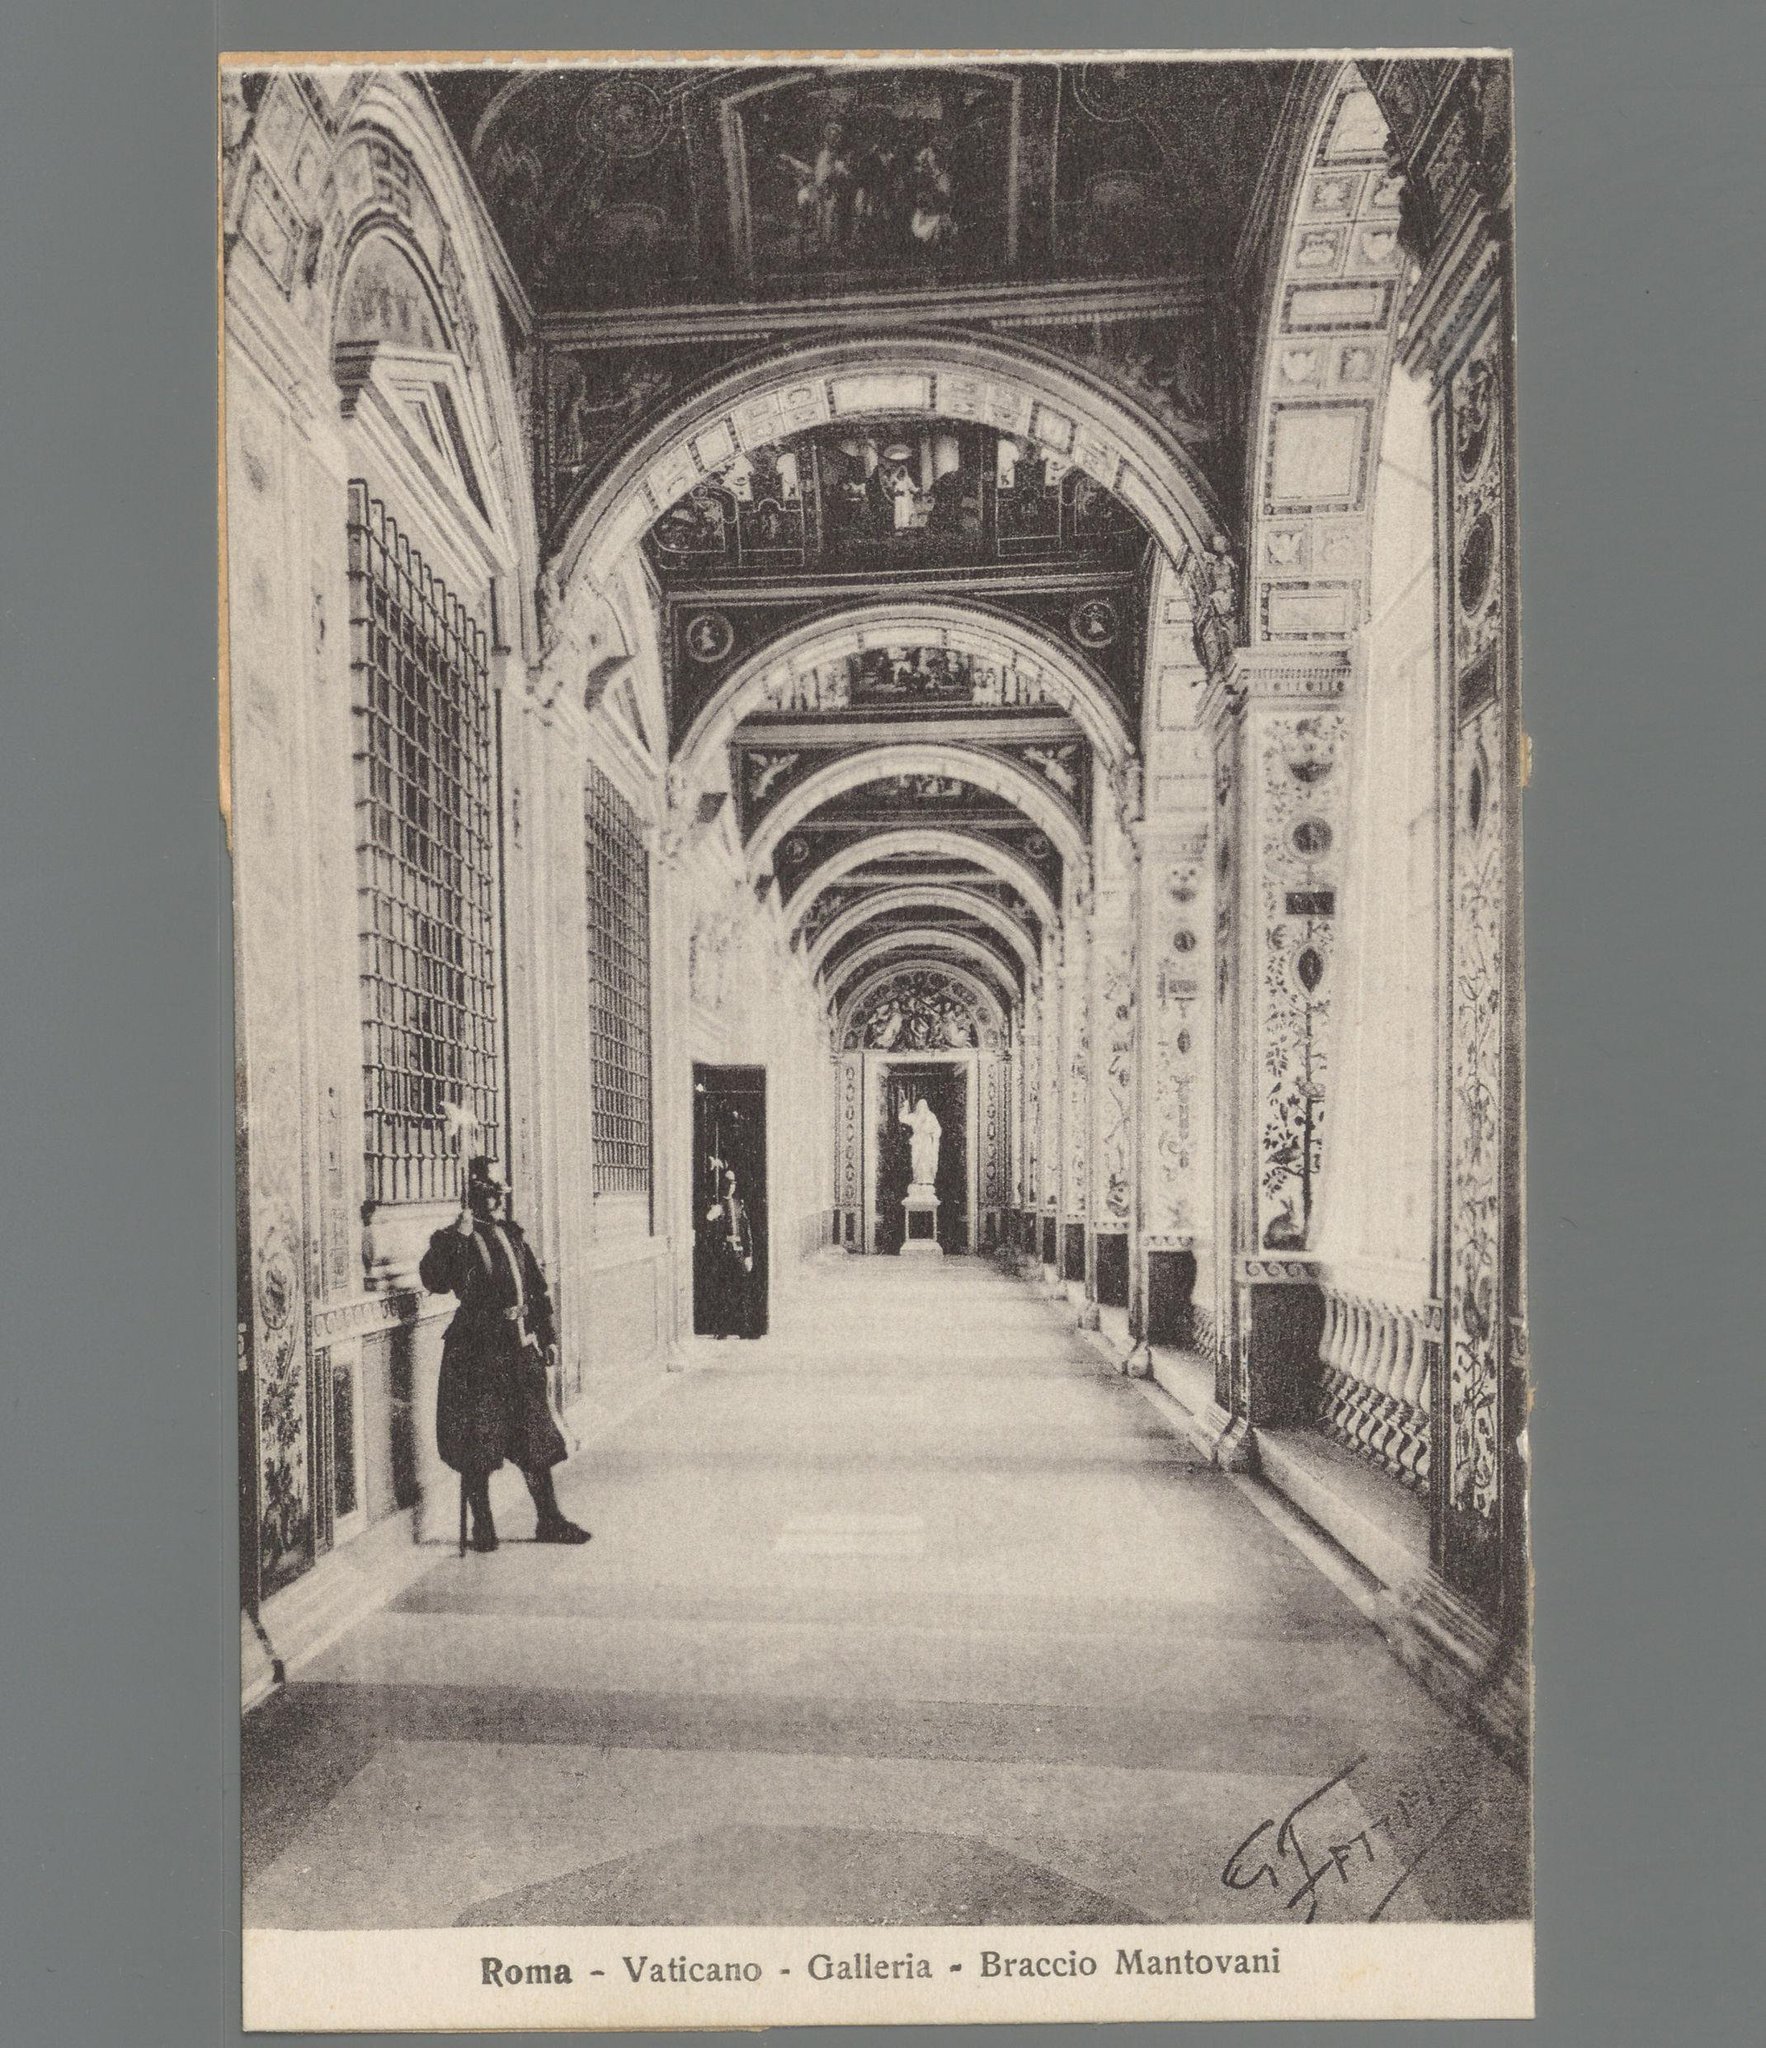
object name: ansichtkaart, prentbriefkaart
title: Roma. Vaticano. Galleria. Braccio Mantovani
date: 1910-1930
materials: cardboard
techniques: photograph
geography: terni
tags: arcade ~ architecture, guard duty, keeping sentry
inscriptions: signature: ‘G. F[..]rr[..]tto’